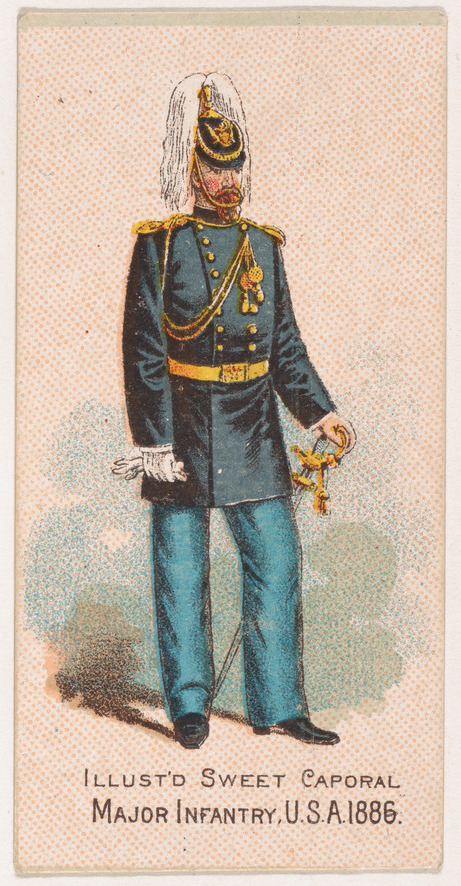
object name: print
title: Major, Infantry, United States Army, 1886, from the Military Series (N224) issued by Kinney Tobacco Company to promote Sweet Caporal Cigarettes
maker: kinney brothers tobacco company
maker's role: publisher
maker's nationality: american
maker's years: 1869-2011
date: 1888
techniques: color lithograph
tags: military,men